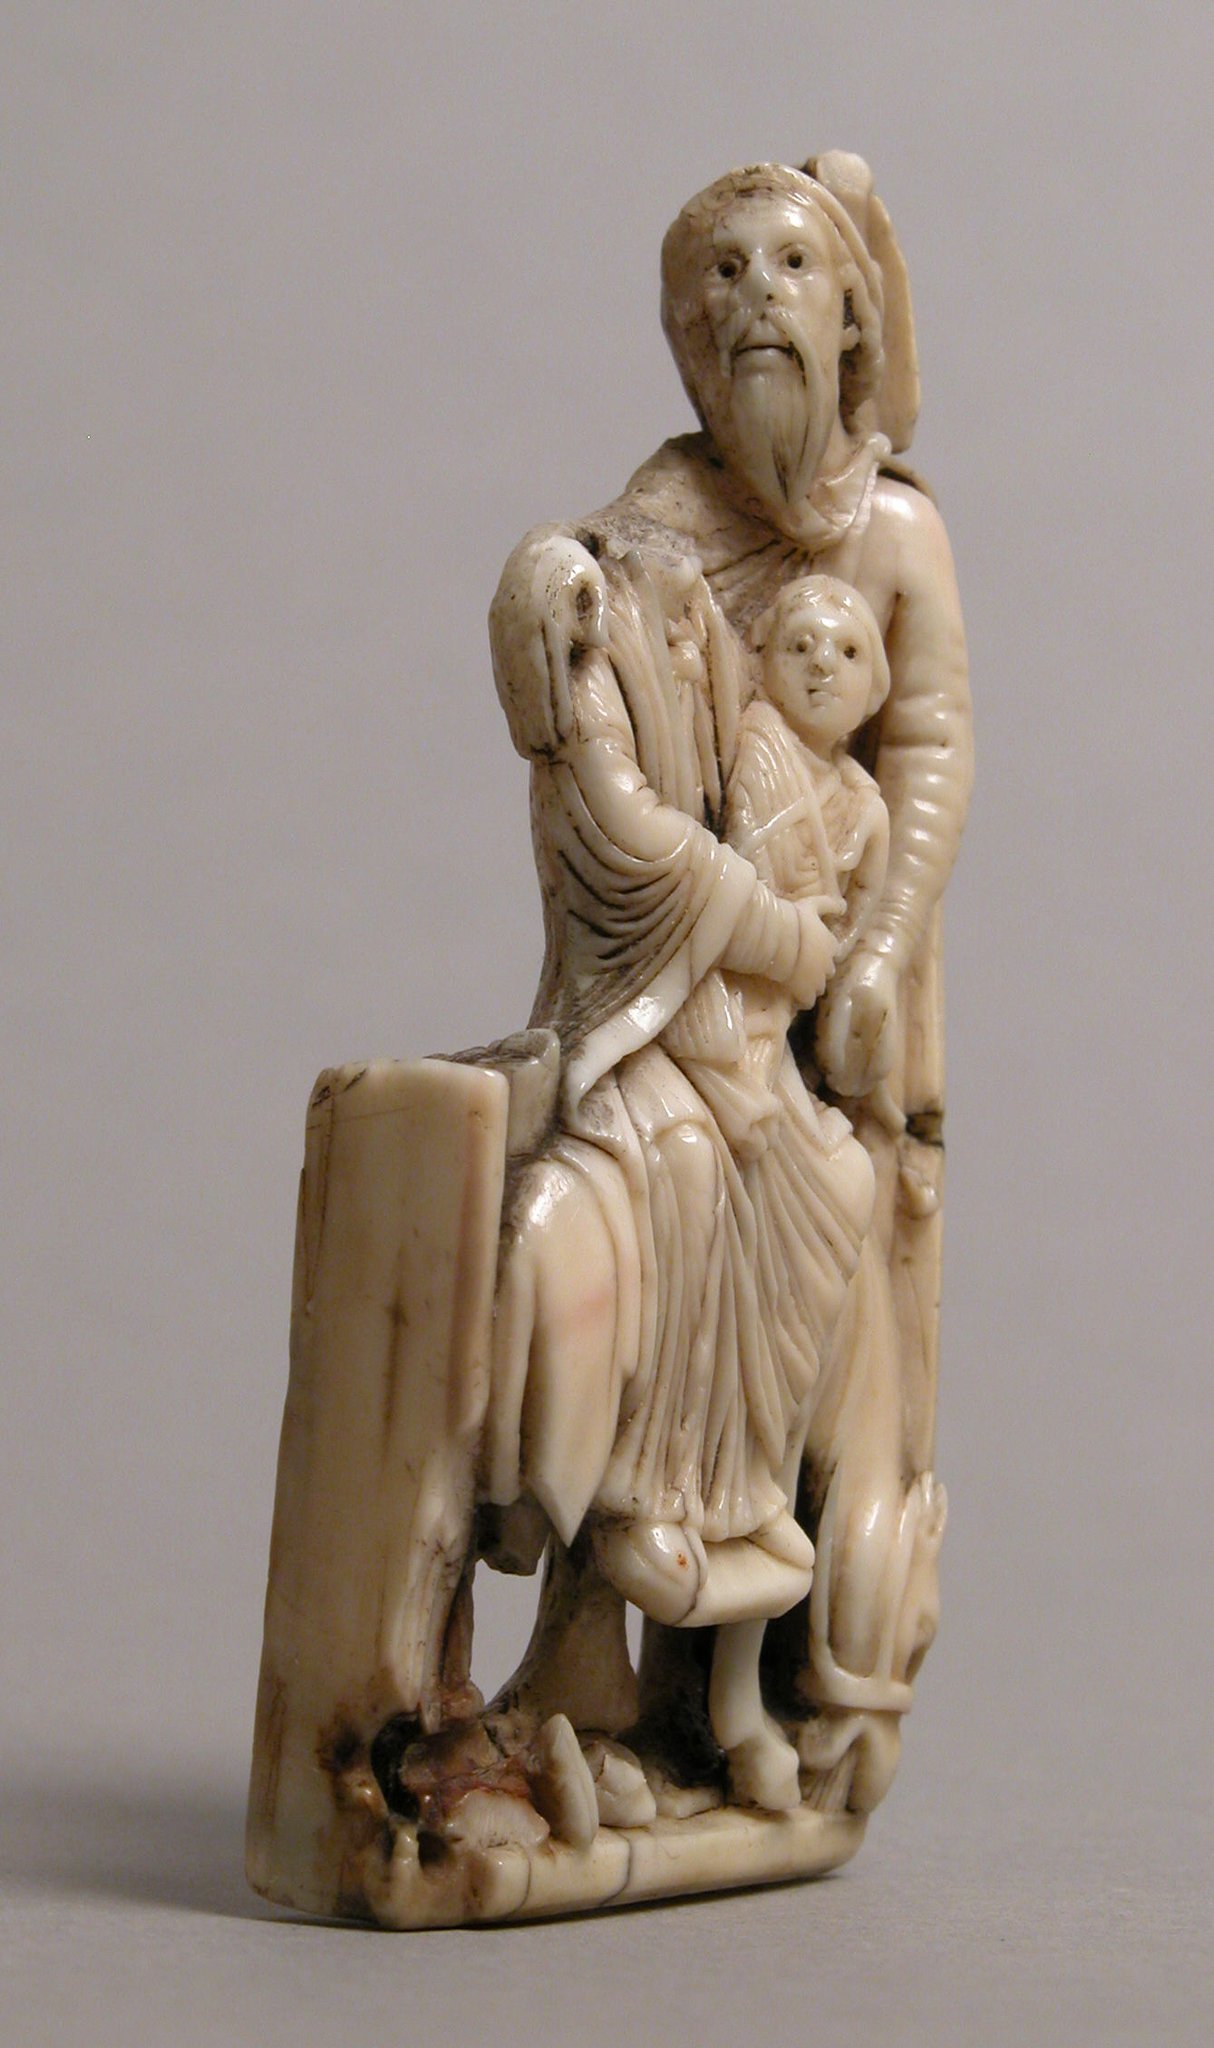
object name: relief statue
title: Relief of the Holy Family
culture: british or north french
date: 1160-1180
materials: ivory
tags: madonna and child